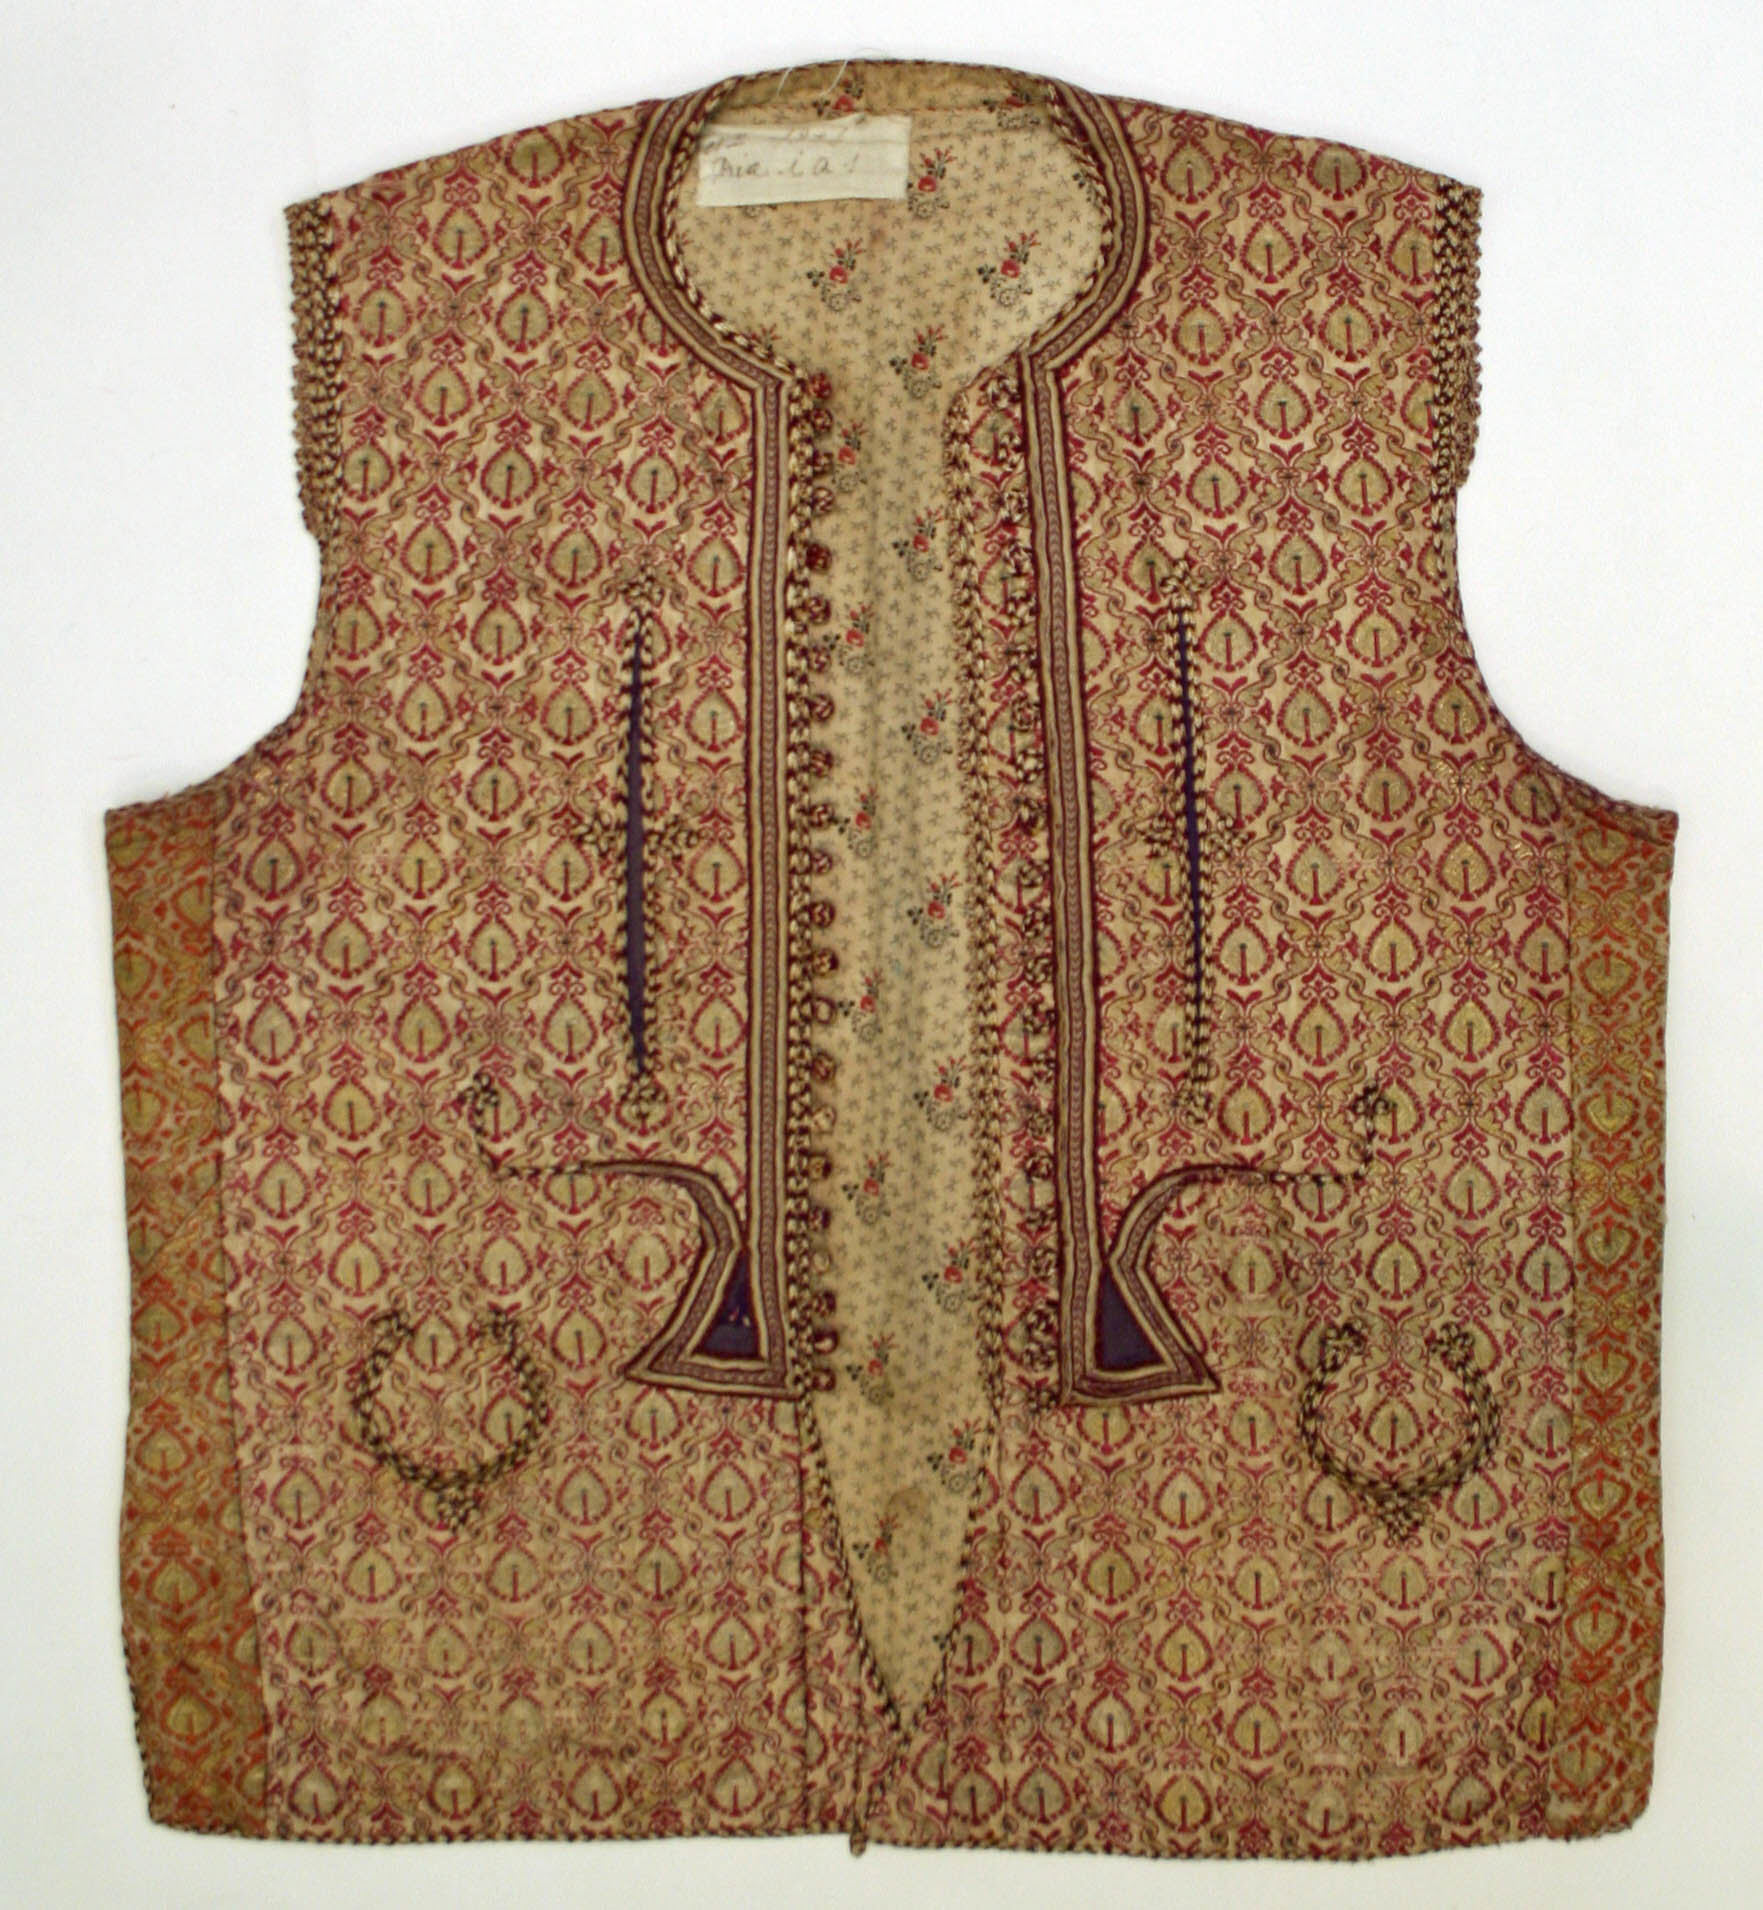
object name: waistcoat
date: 1801-1900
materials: metal thread, silk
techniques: brocade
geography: india